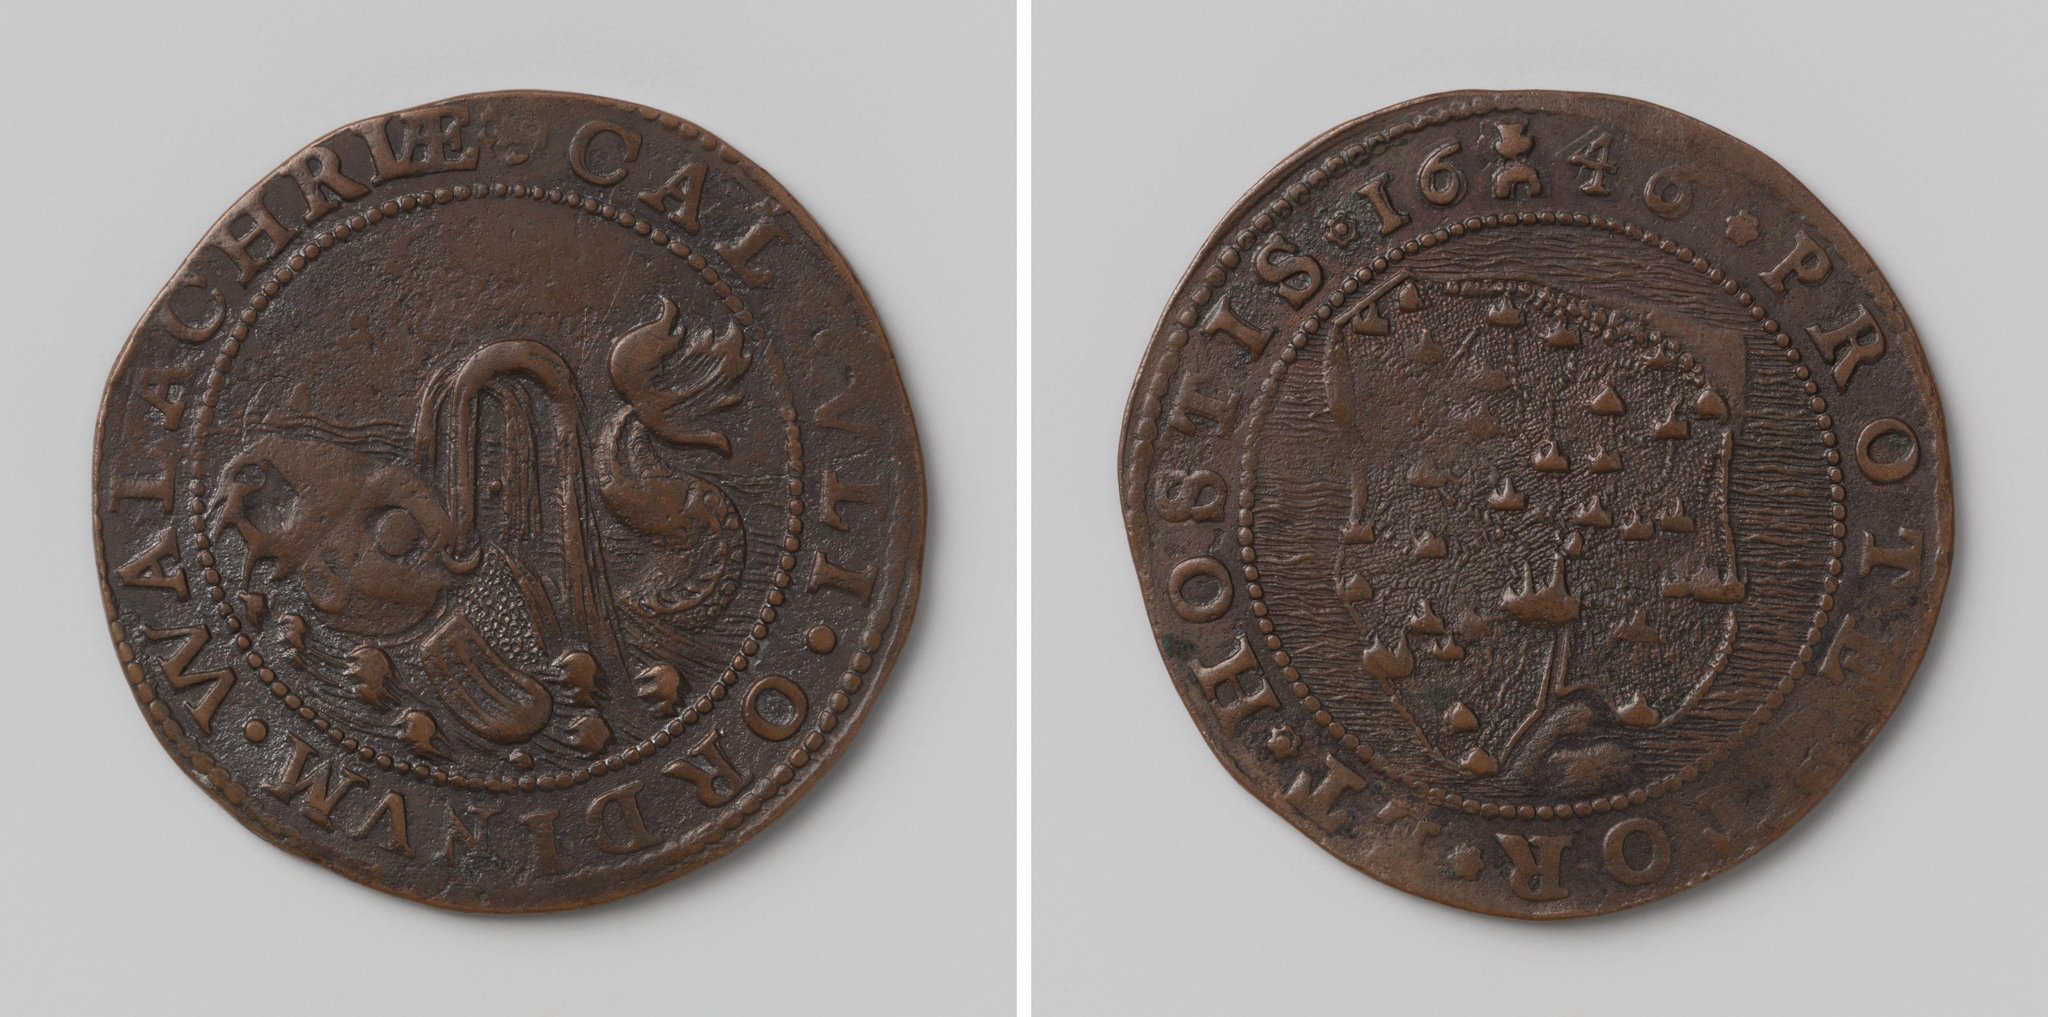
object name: jeton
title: Staten van Walcheren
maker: johannes looff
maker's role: die cutter, draughtsman, print maker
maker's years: -1651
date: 1646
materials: copper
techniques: striking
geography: middelburg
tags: staten van walcheren, walcheren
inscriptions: inscription: ‘Mt CALCVLI. ORDINVM/ WALACHRIAE’, inscription: ‘1646. PROTECTOR. ET. HOSTIS’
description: Koperen penning. Voorzijde: walvis met staart in lucht binnen omschrift. Keerzijde: kaart van eiland Walcheren binnen omschrift.